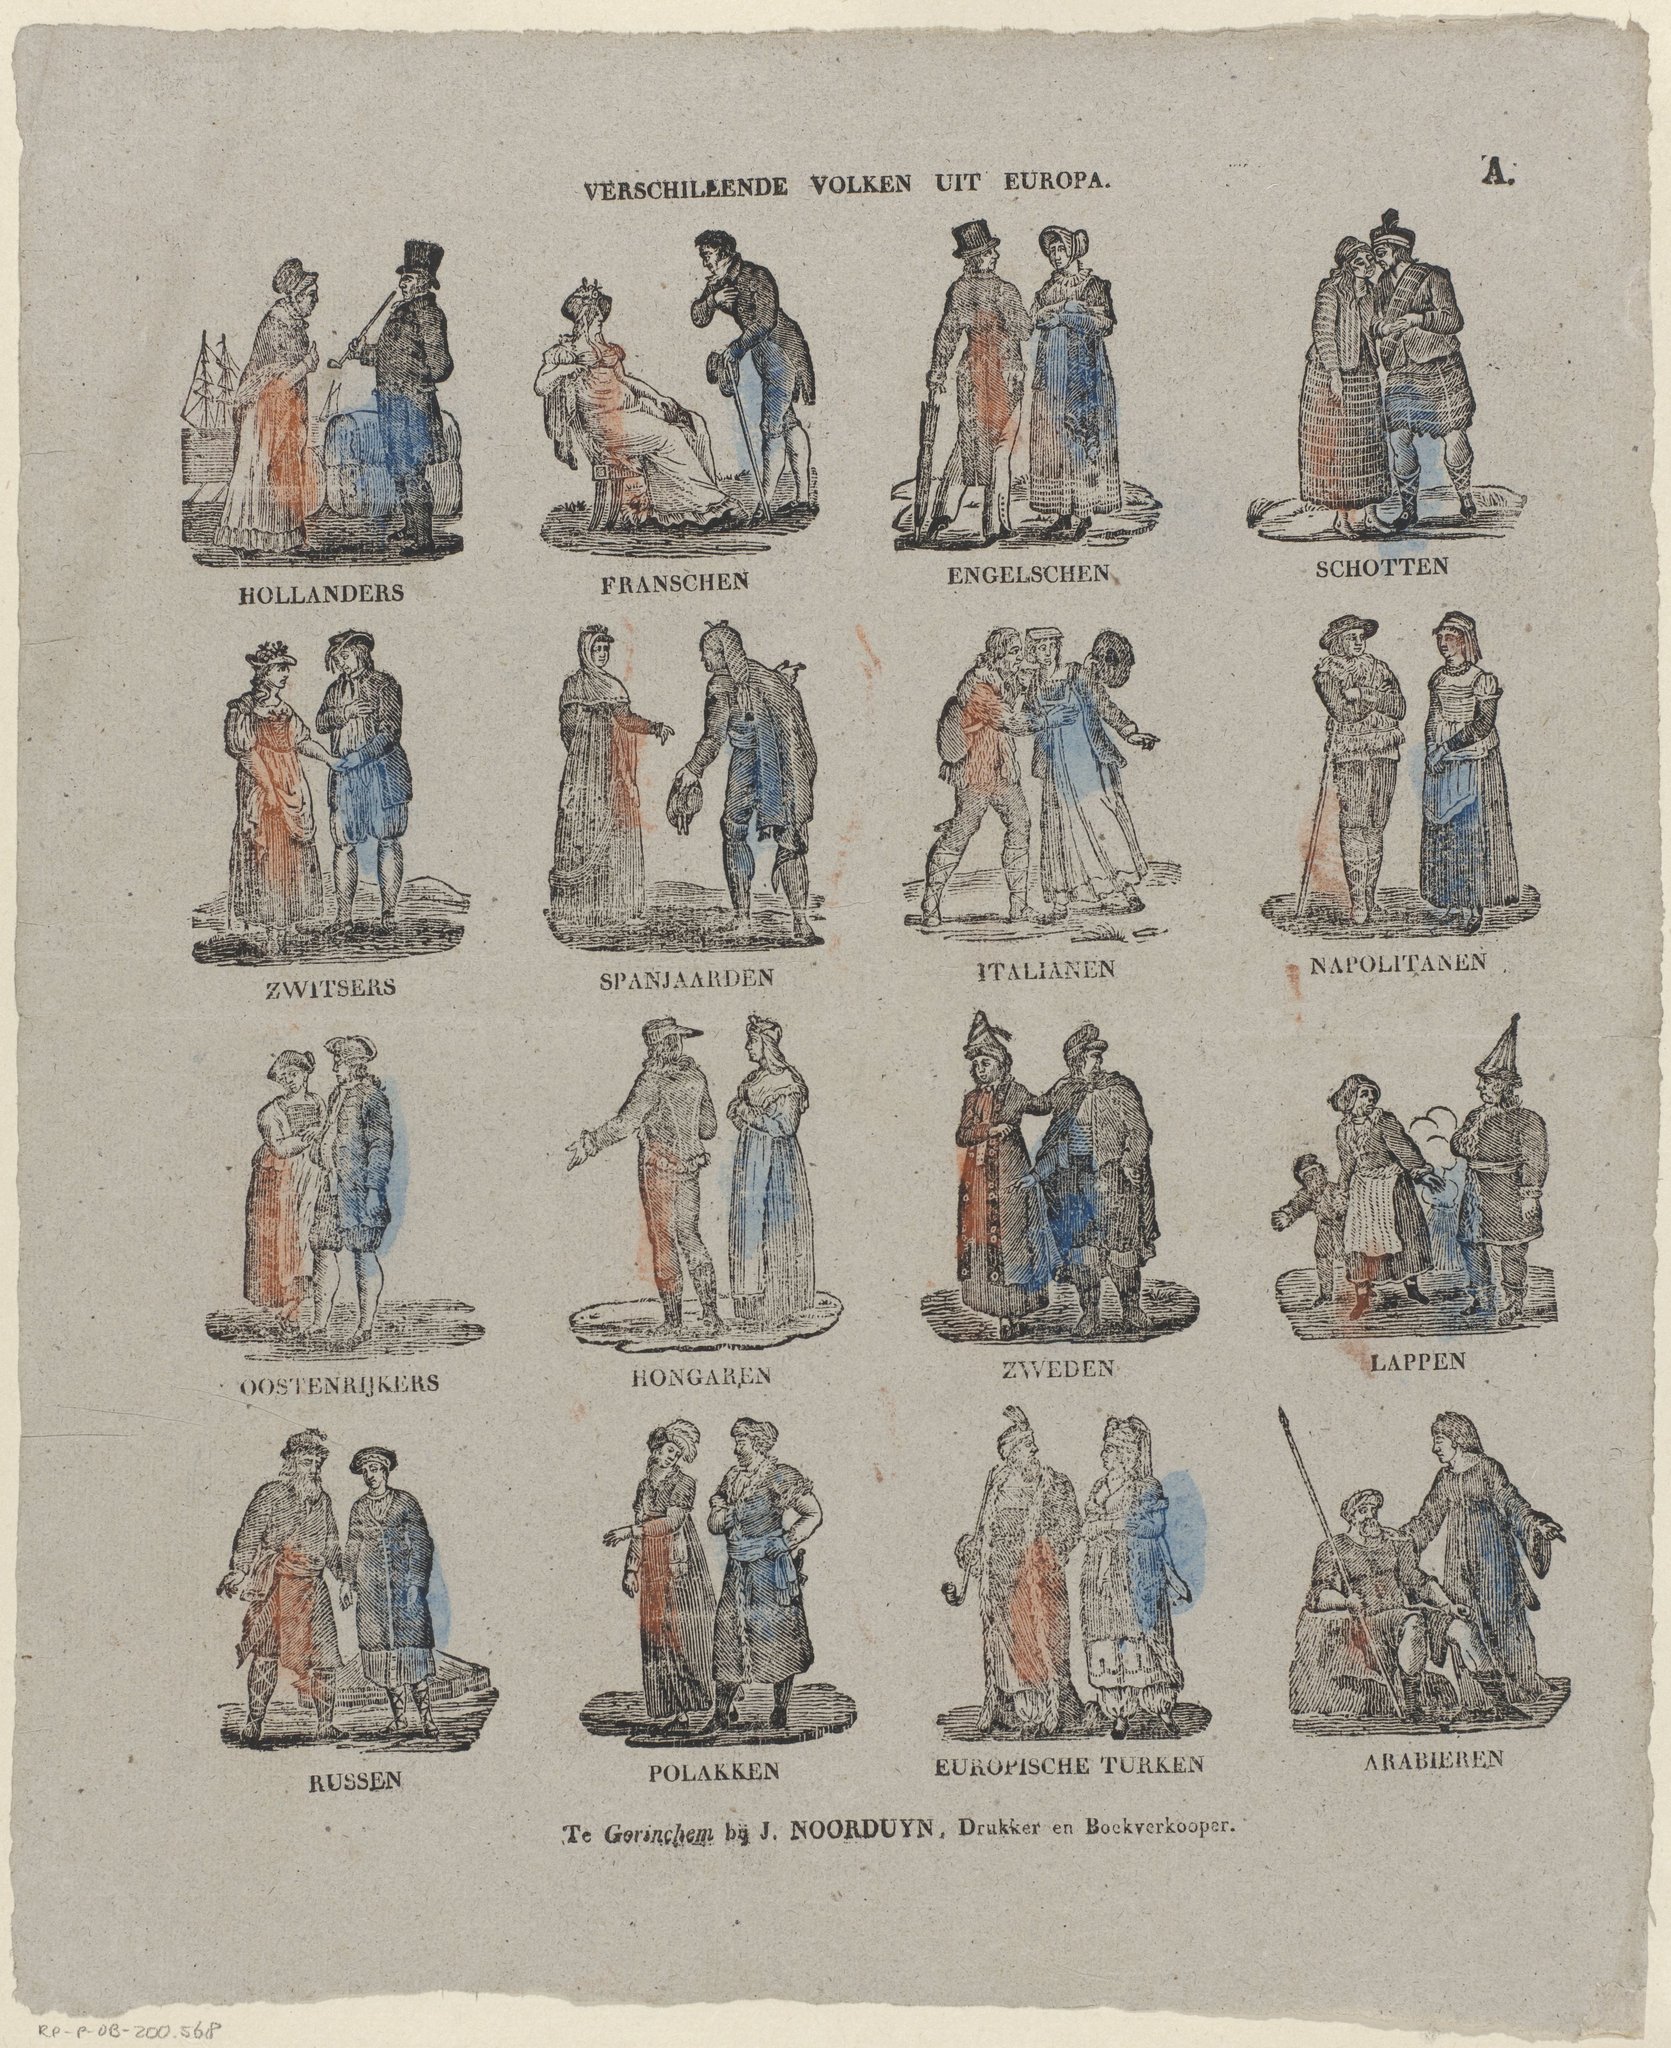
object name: print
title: Verschillende volken uit Europa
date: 1819-1840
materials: paper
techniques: colour, letterpress printing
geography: gorinchem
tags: europeans, human races; peoples; nationalities, europe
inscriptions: collector's mark: Lugt 2760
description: Blad met 16 voorstellingen van telkens een man en een vrouw uit een Europees land of een Europese stad, waaronder een stel Fransen, een stel Schotten en een stel Zweden. Onder elke voorstelling een onderschrift. Gemerkt rechtsboven: A.